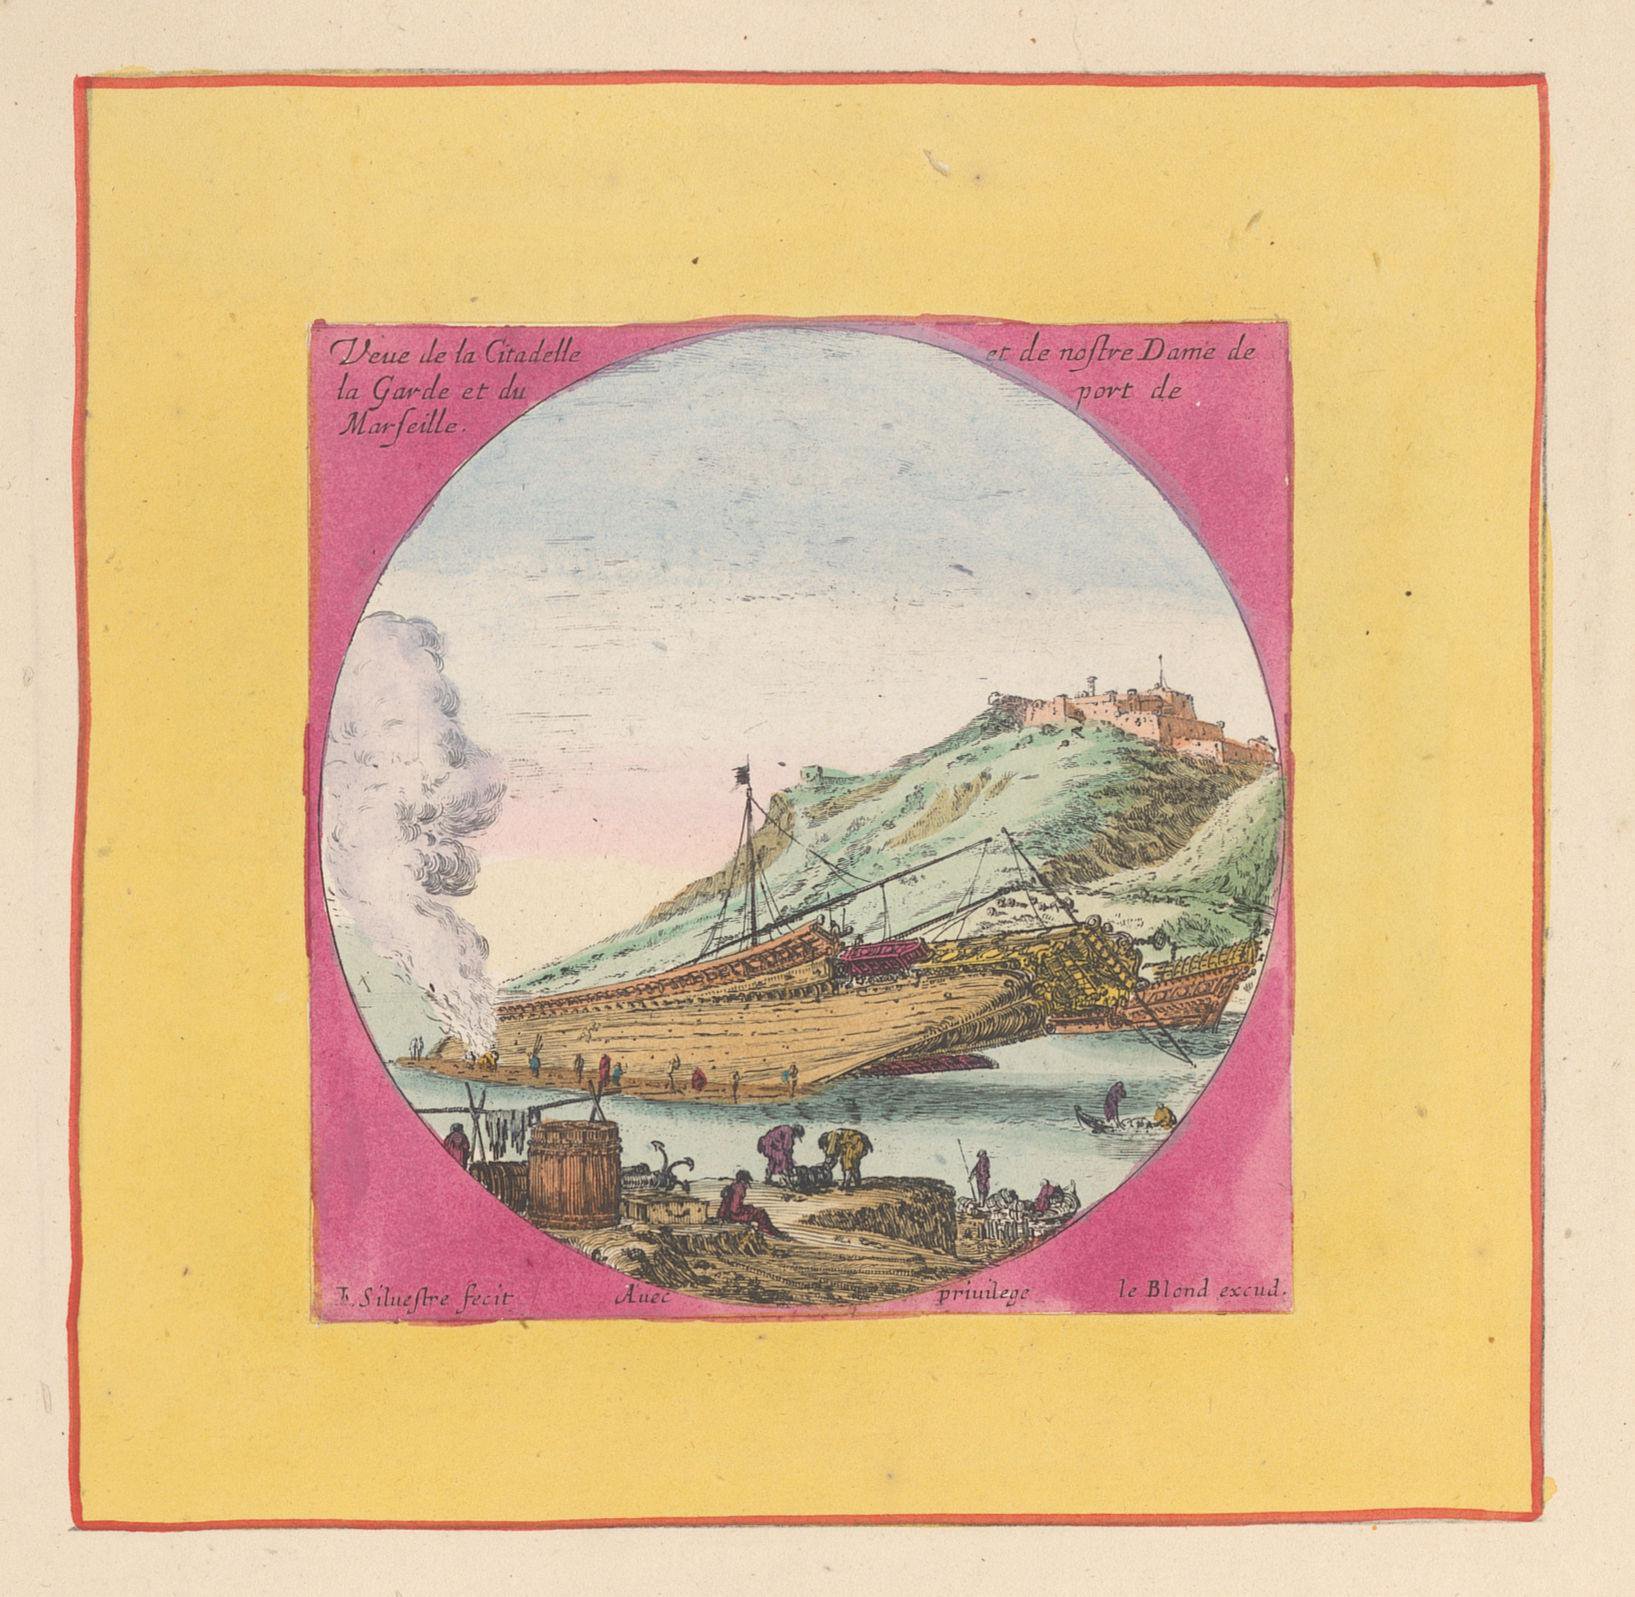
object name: album leaf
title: Landschappen in Italië en Frankrijk in cirkels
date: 1648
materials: paper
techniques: etching, hand coloring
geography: the hague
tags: city-view in general; 'veduta', ship in the roads, roadstead, marseille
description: Uit een ongenummerde serie zonder titel van in totaal zes prenten.